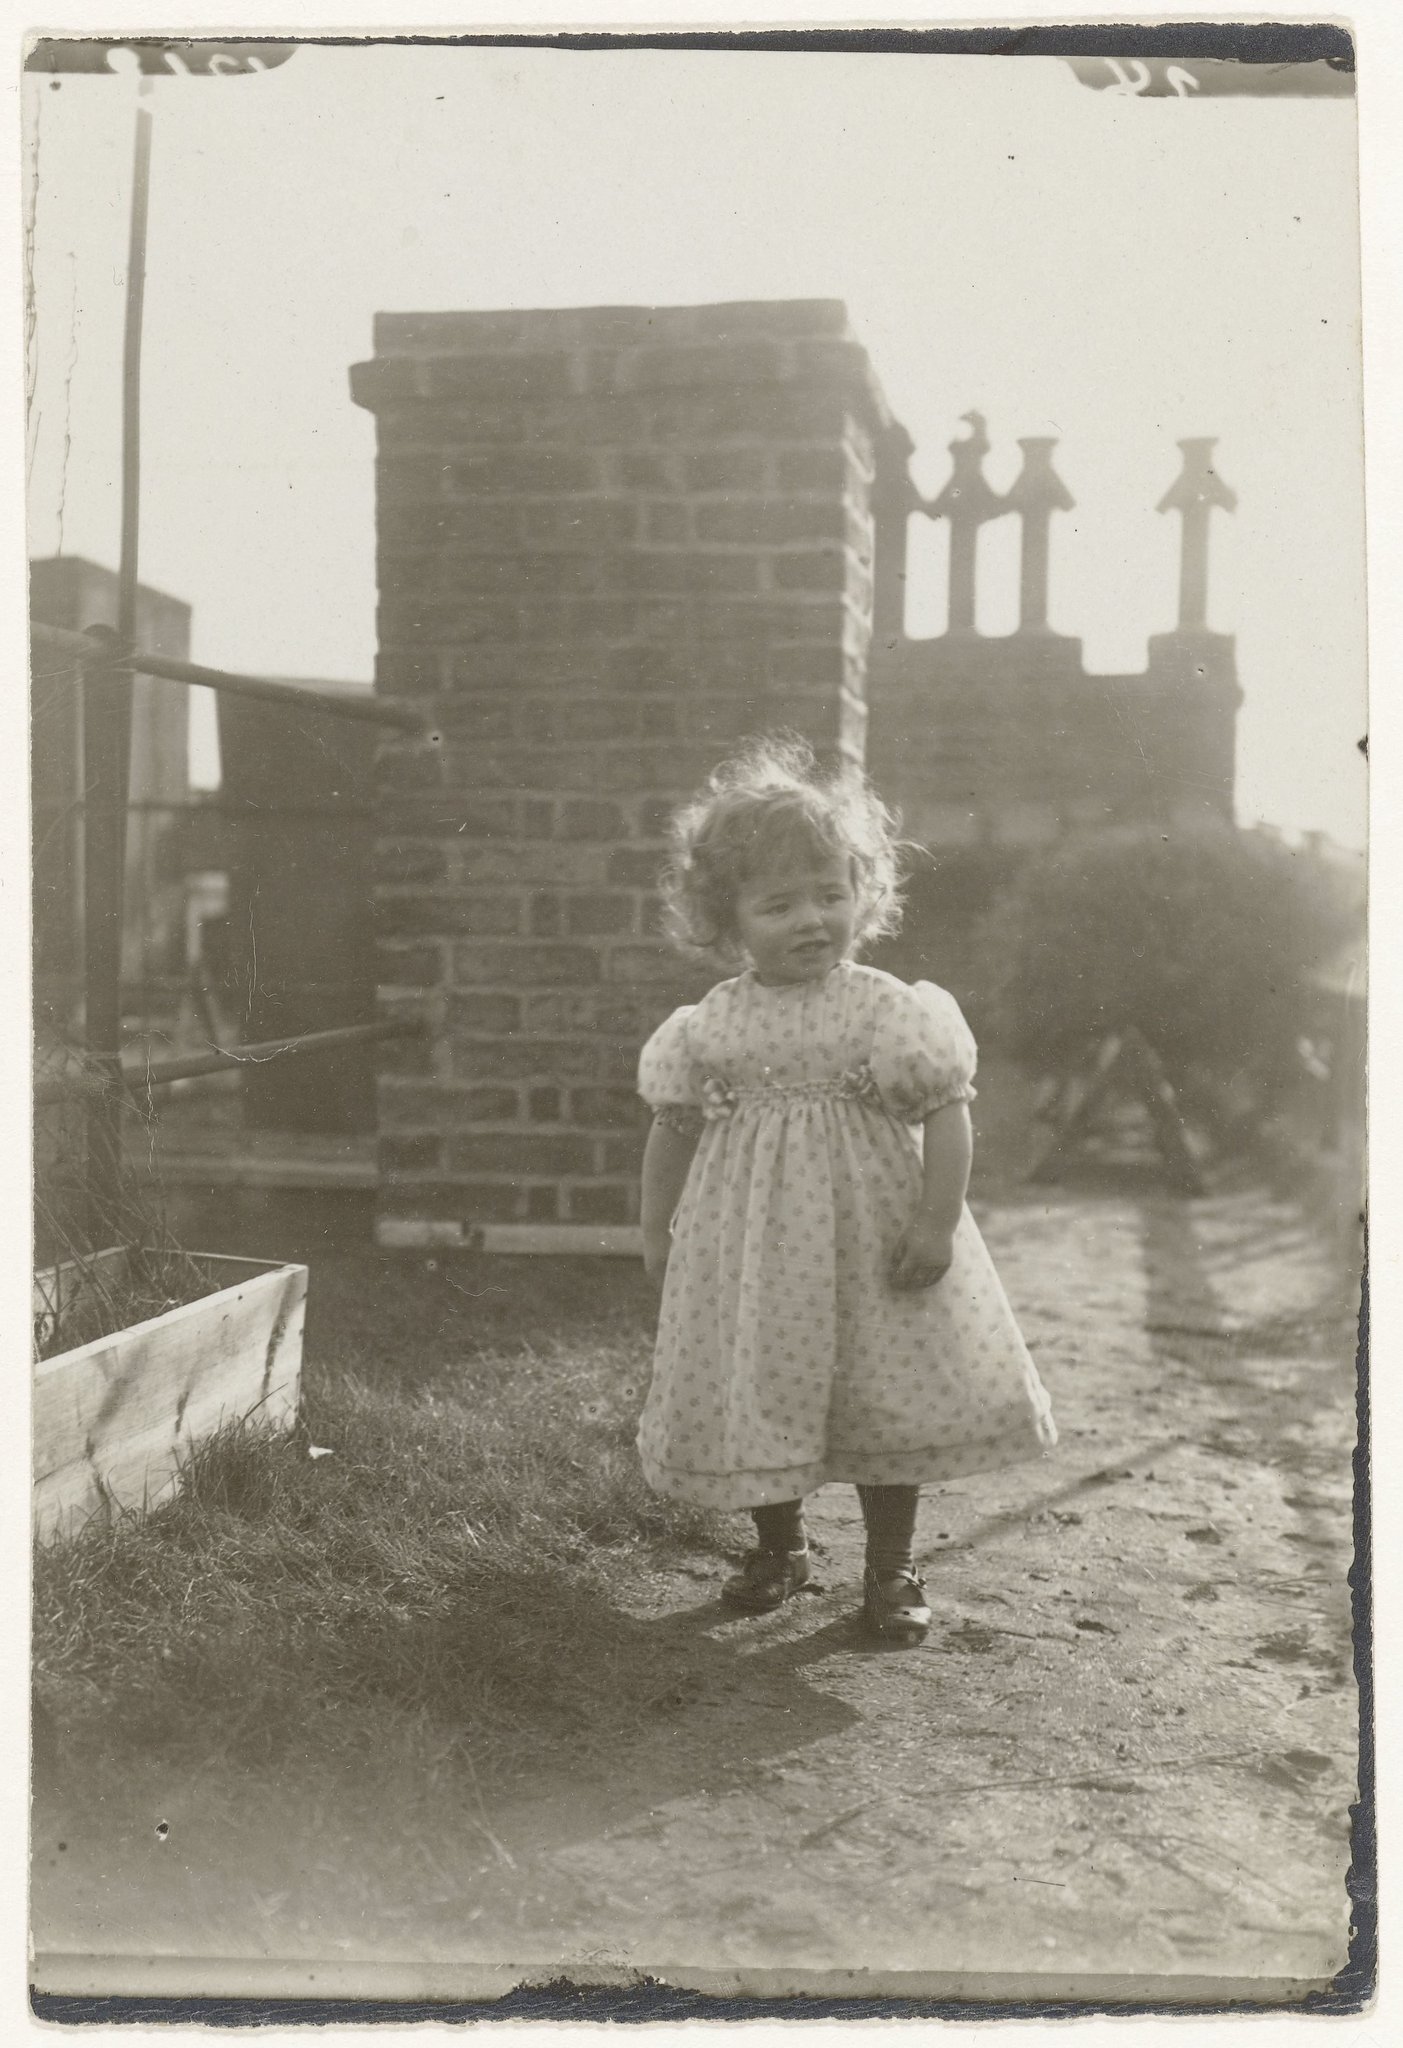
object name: photograph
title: Marba Titzenthaler, dochter van de fotograaf, op het dakterras van het woonhuis in de Friedrichstrasse, Berlijn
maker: waldemar titzenthaler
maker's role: fotograaf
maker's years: 1869-1937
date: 1912-1913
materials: paper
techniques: gelatin silver print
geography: berlin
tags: roof garden, tot, toddler ~ the ages of man, berlin